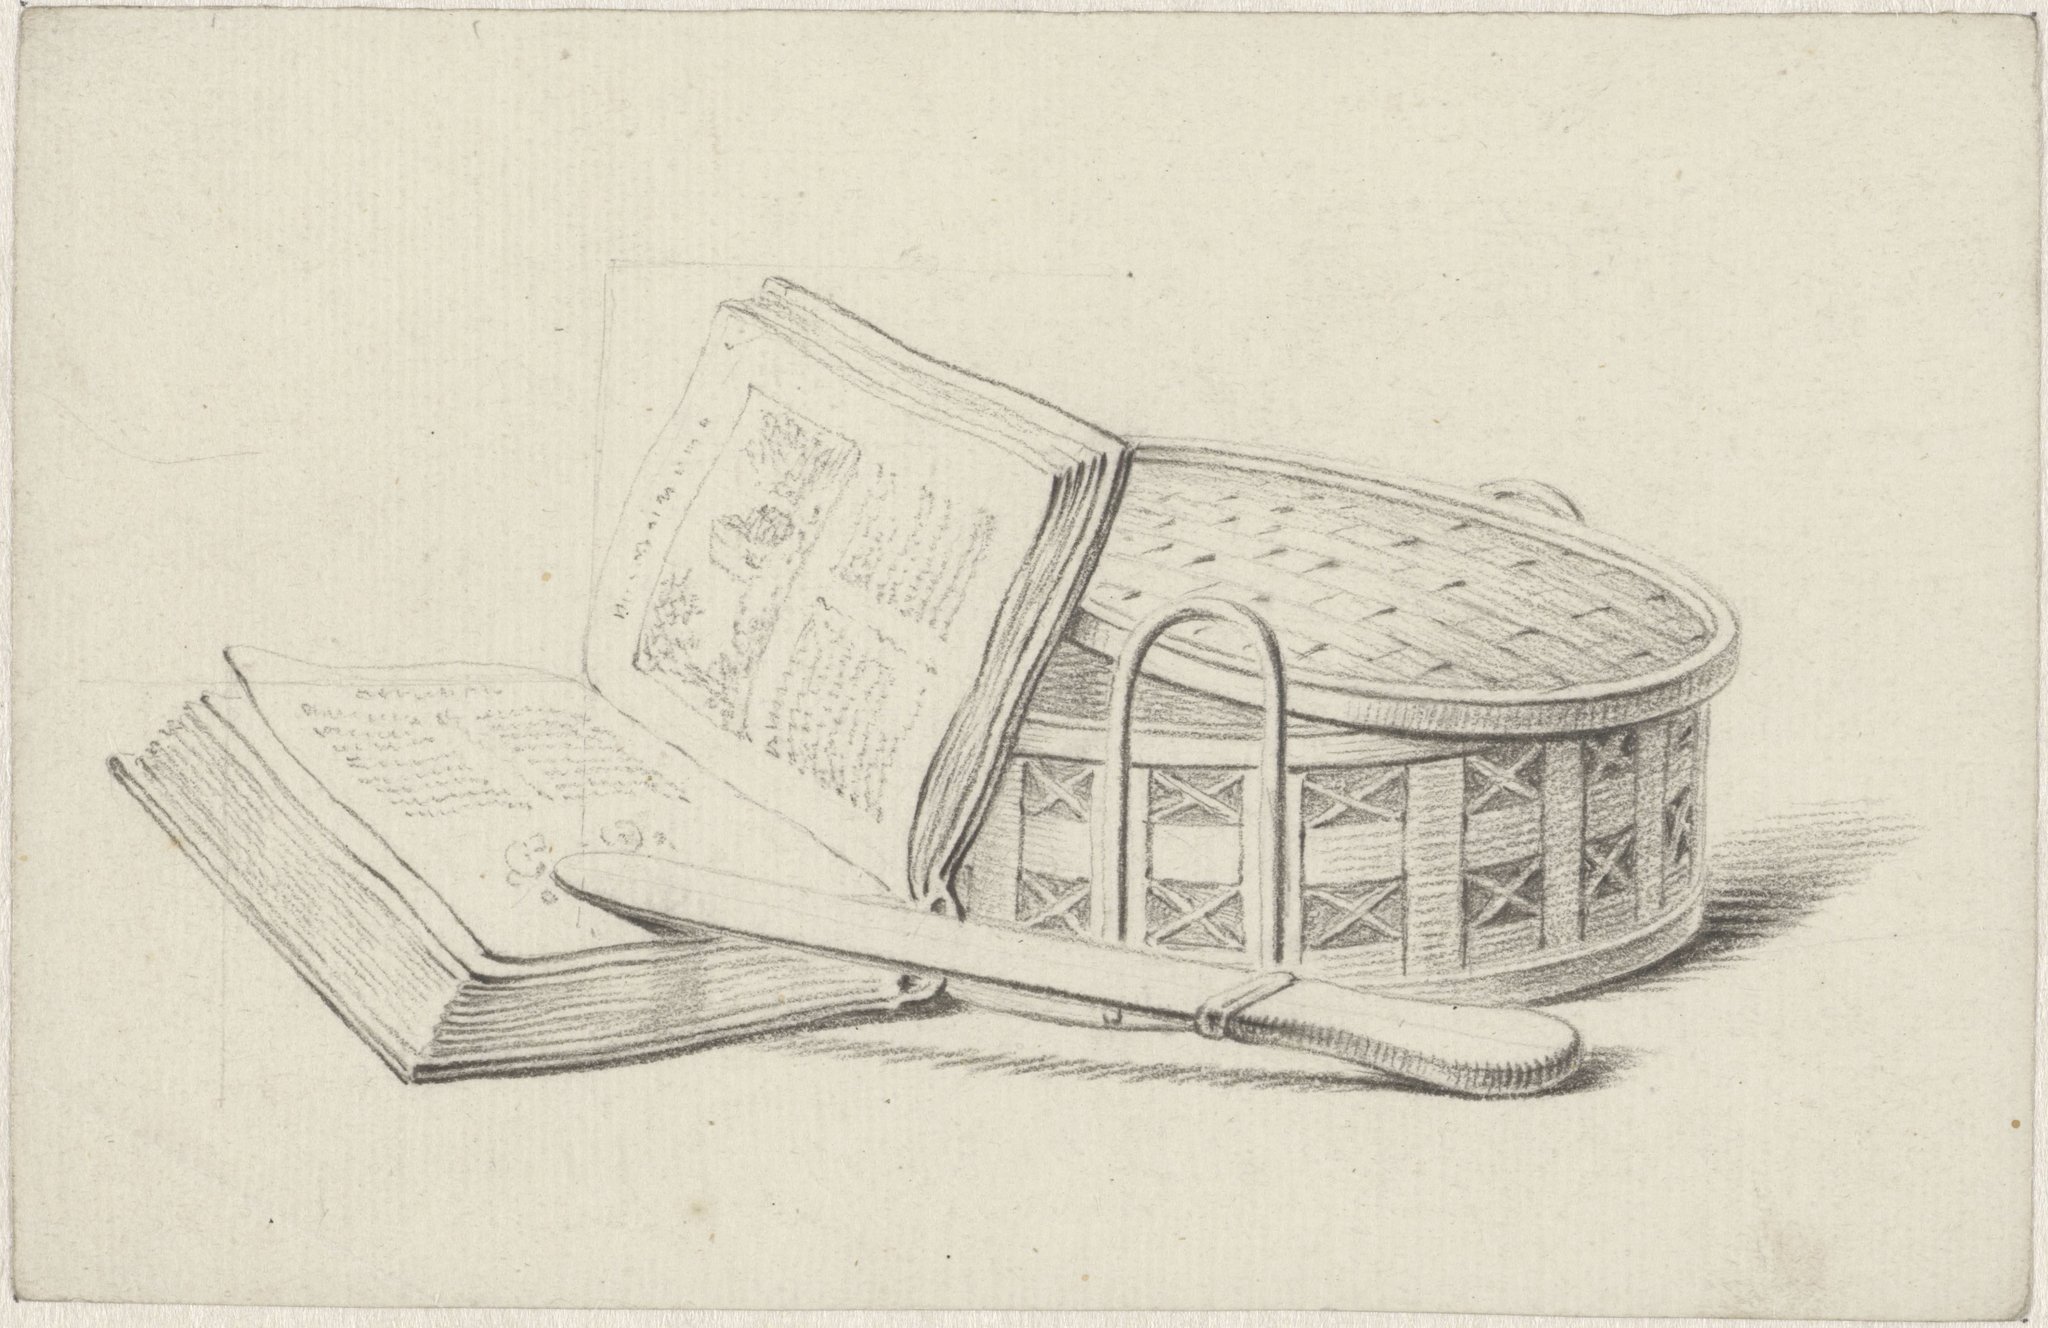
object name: drawing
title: Stilleven met boek, briefopener en mandje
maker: pieter de goeje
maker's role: draughtsman, print maker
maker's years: 1789-1859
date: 1789-1859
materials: chalk, paper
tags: book, still life of miscellaneous objects